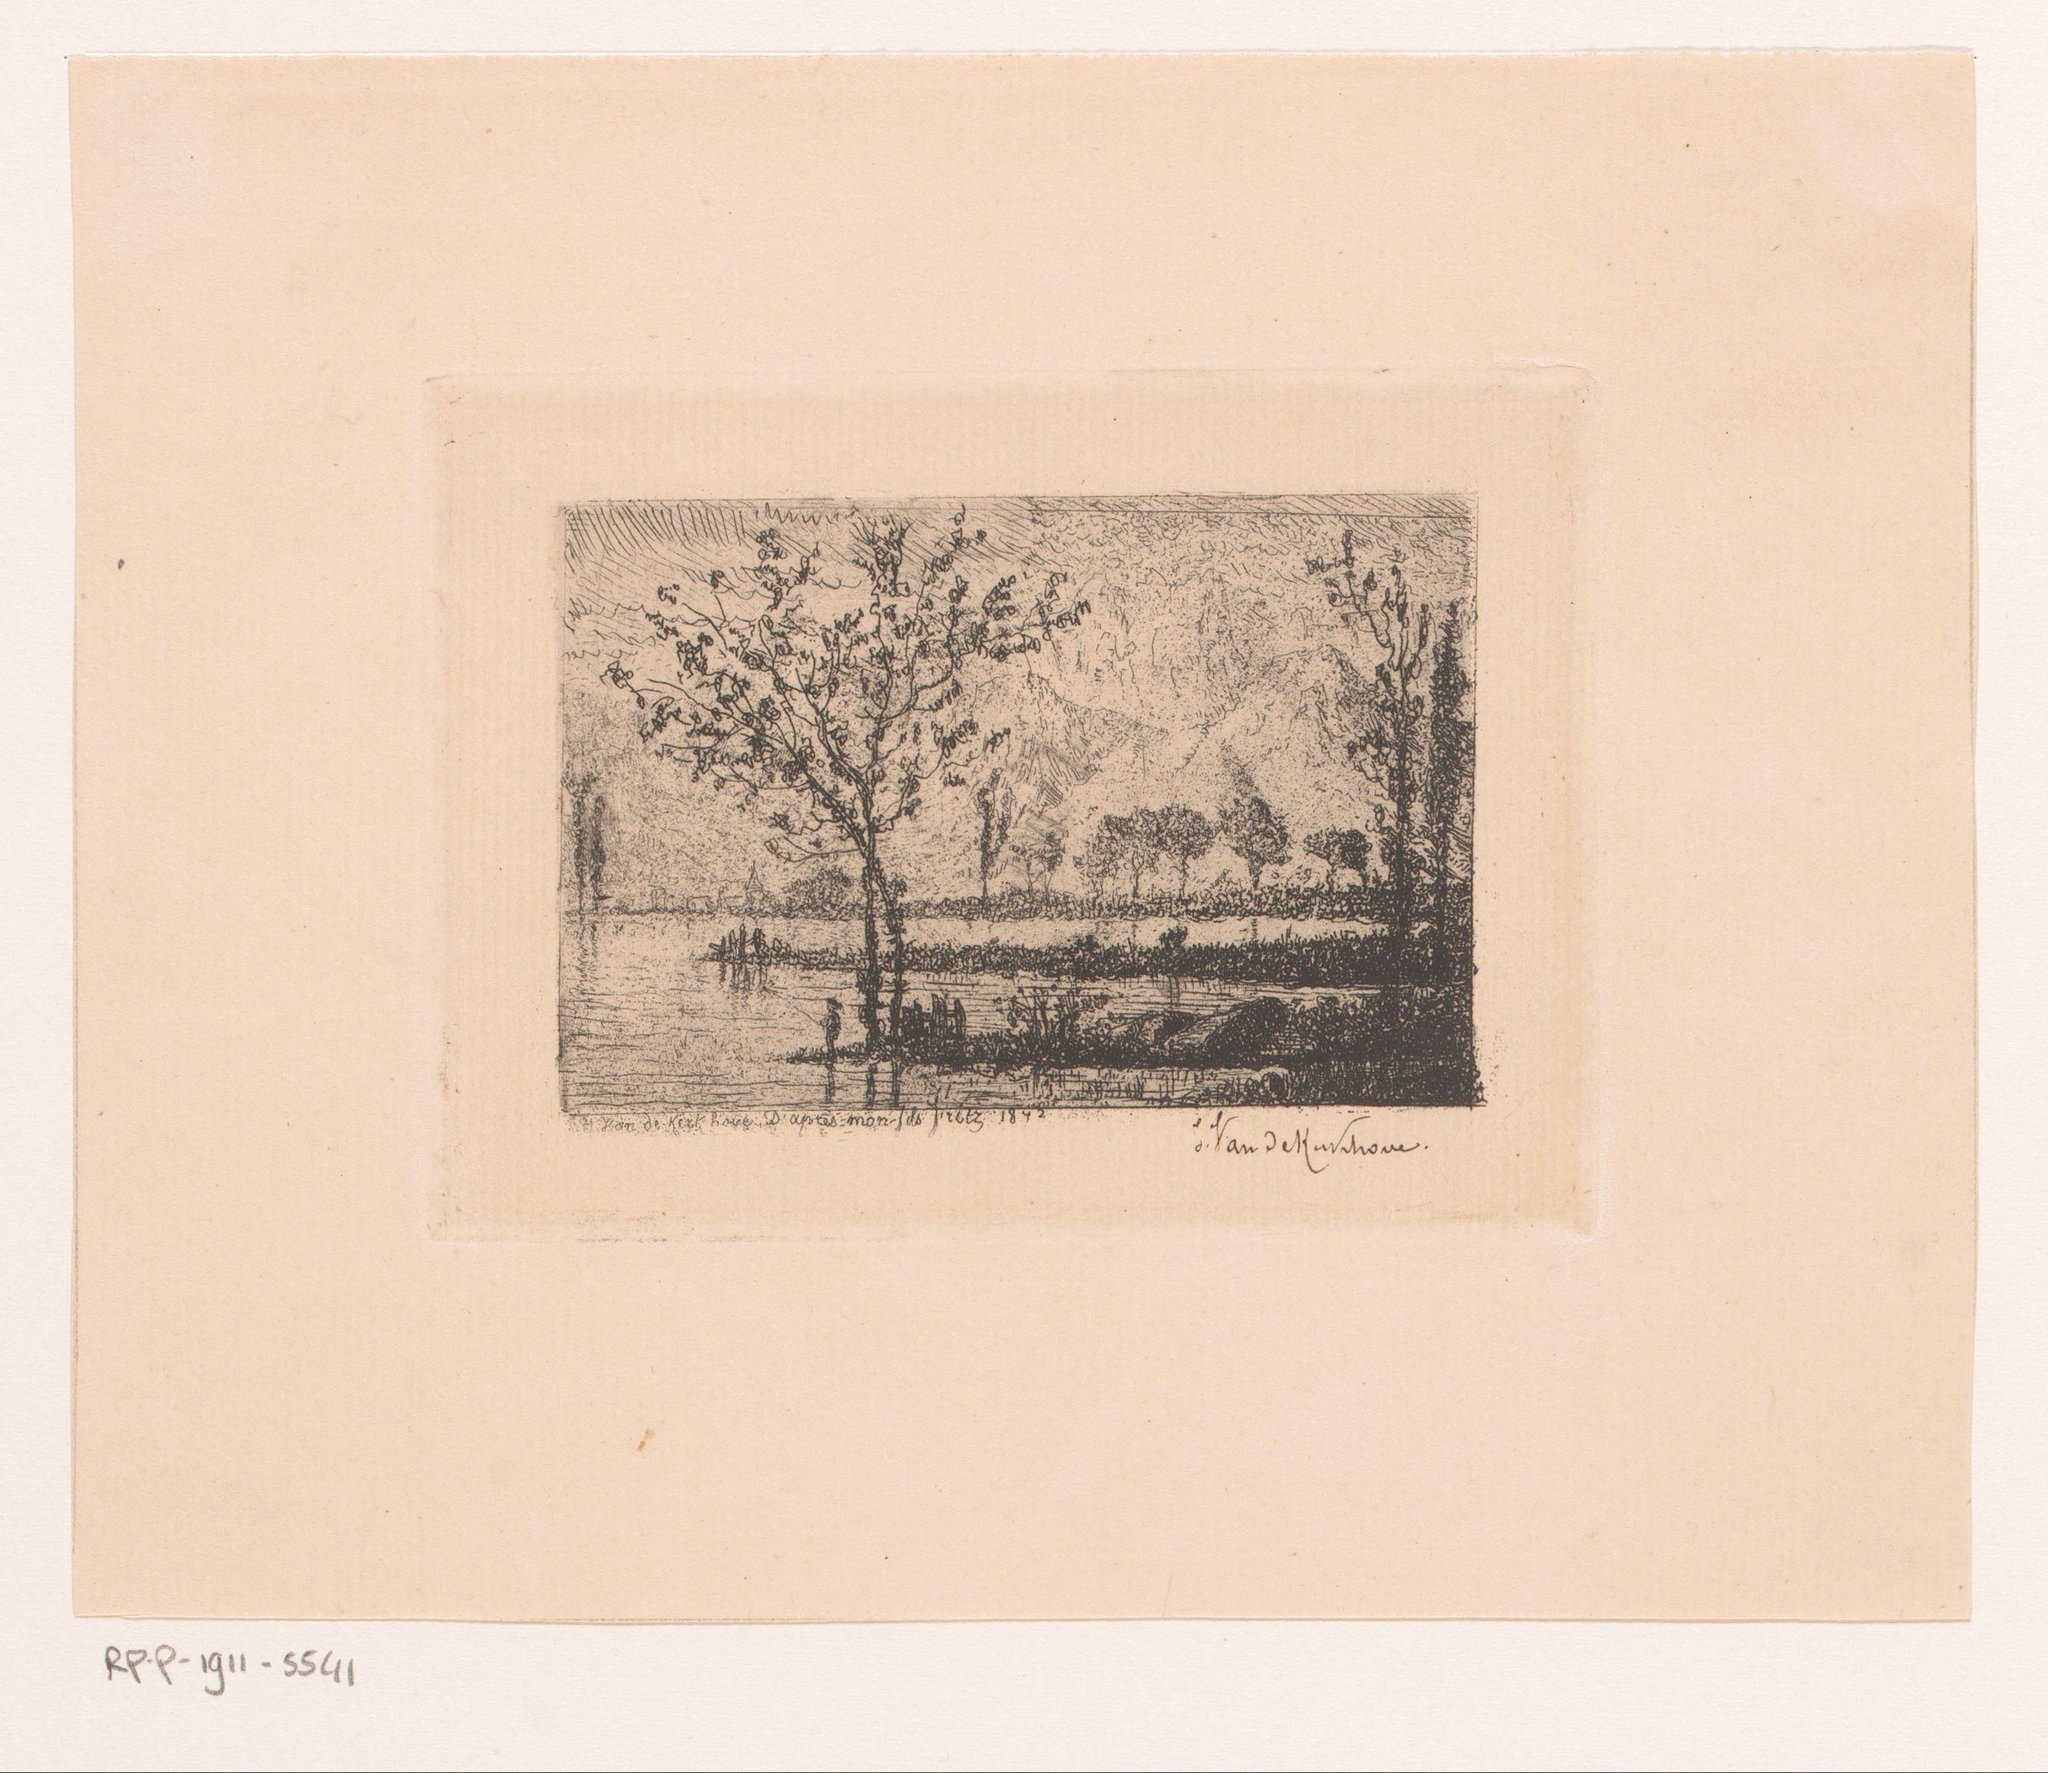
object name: print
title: Figuur met hengel aan de waterkant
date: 1873-1881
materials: paper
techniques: etching, intaglio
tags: water course, fisherman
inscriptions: collector's mark: Lugt 2228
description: De etsen naar de schilderijen van Frédéric Van de Kerkhove werden na zijn dood door zijn vader en zuster gemaakt en uitgegeven in twee reeksen. De eerste werd in 1877 uitgegeven door het Journal des Beaux-Arts et de la Littérature: Cahier de 25 Eaux-fortes d'après Frédéric van de Kerkhove, gravées par son père et sa sœur. De tweede reeks van 126 etsen, ook in 1877, werd in Parijs uitgegeven bij A. Lévy onder de titel Cent eaux-fortes gravées par J. Van de Kerkhove d'après les tableaux de Frédéric Van de Kerkhove, mort en 1873 à l'âge de 10 ans et 11 mois.